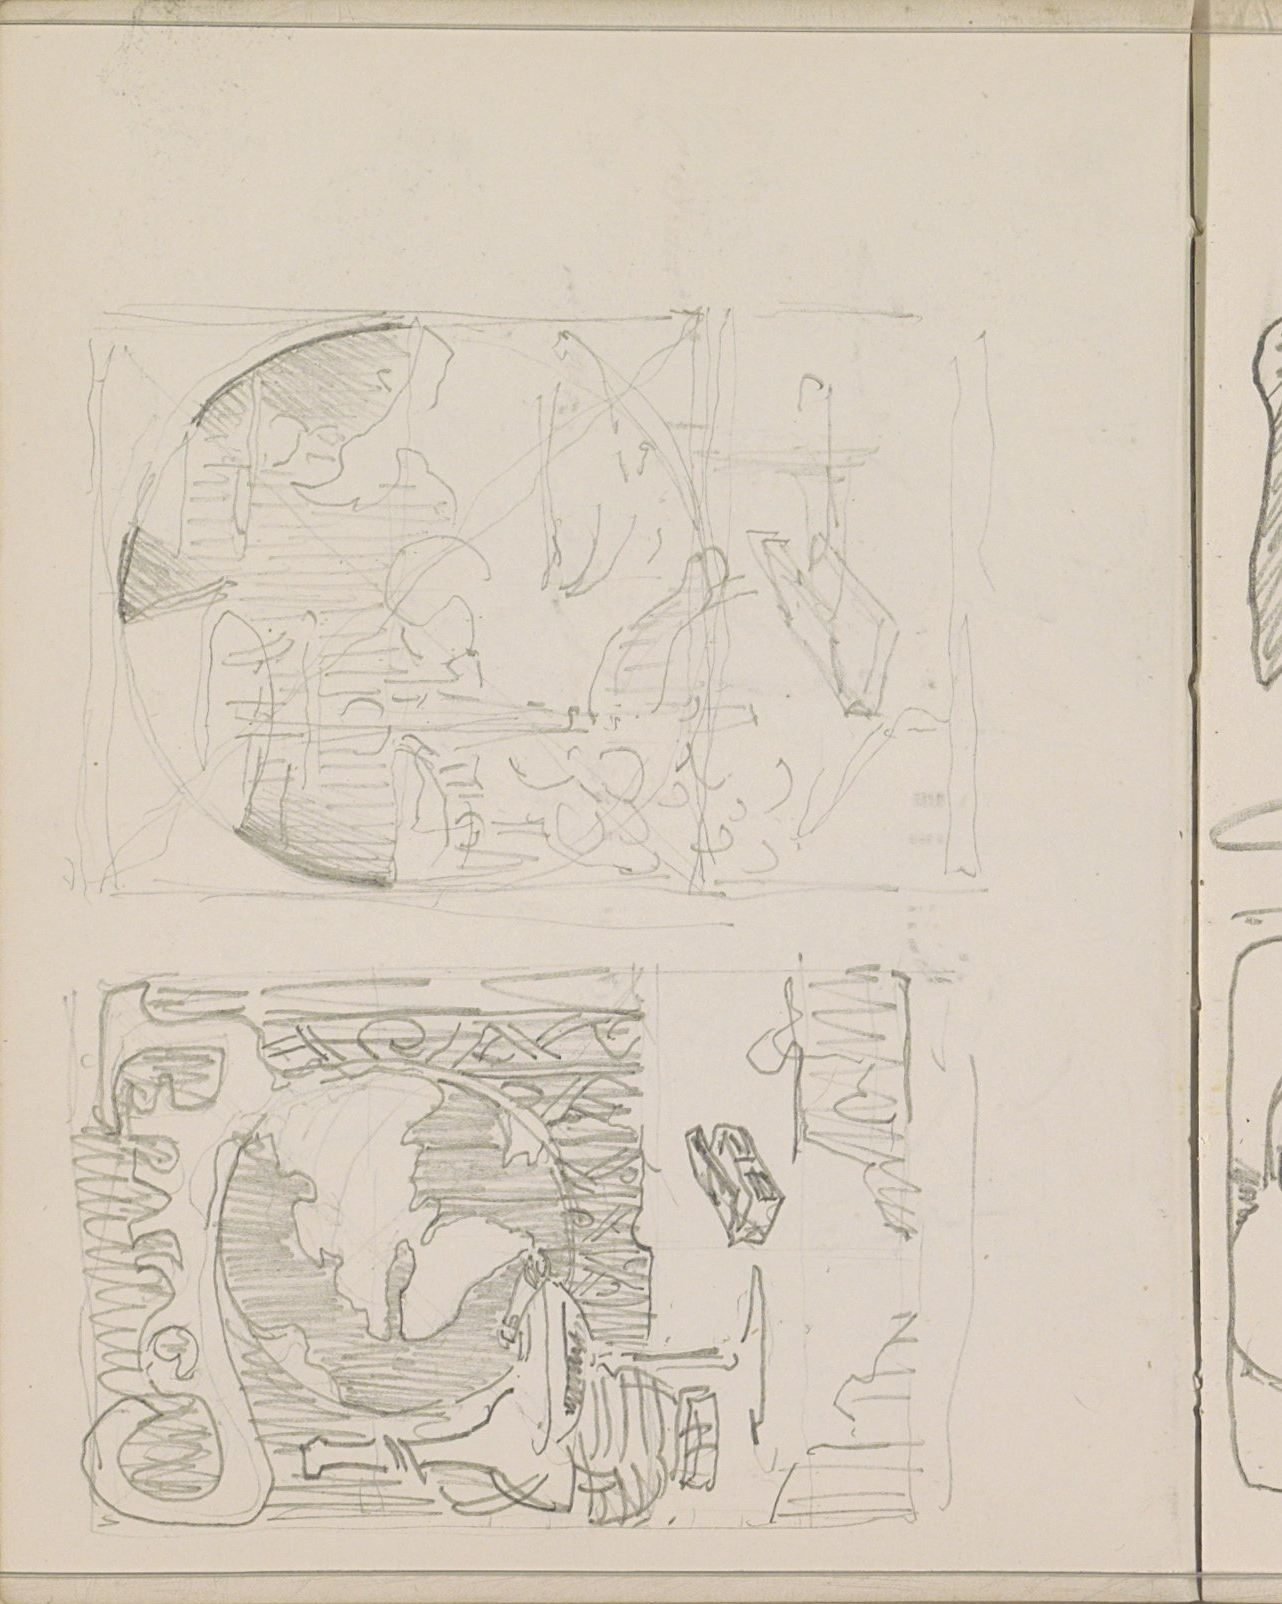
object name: sketchbook leaf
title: Stilleven met een globe, wijnfles, glas en doosje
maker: reijer stolk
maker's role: draughtsman, print maker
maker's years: 1896-1945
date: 1916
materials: paper, pencil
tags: still life of miscellaneous objects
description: Blad 35 verso uit een schetsboek met 72 bladen.